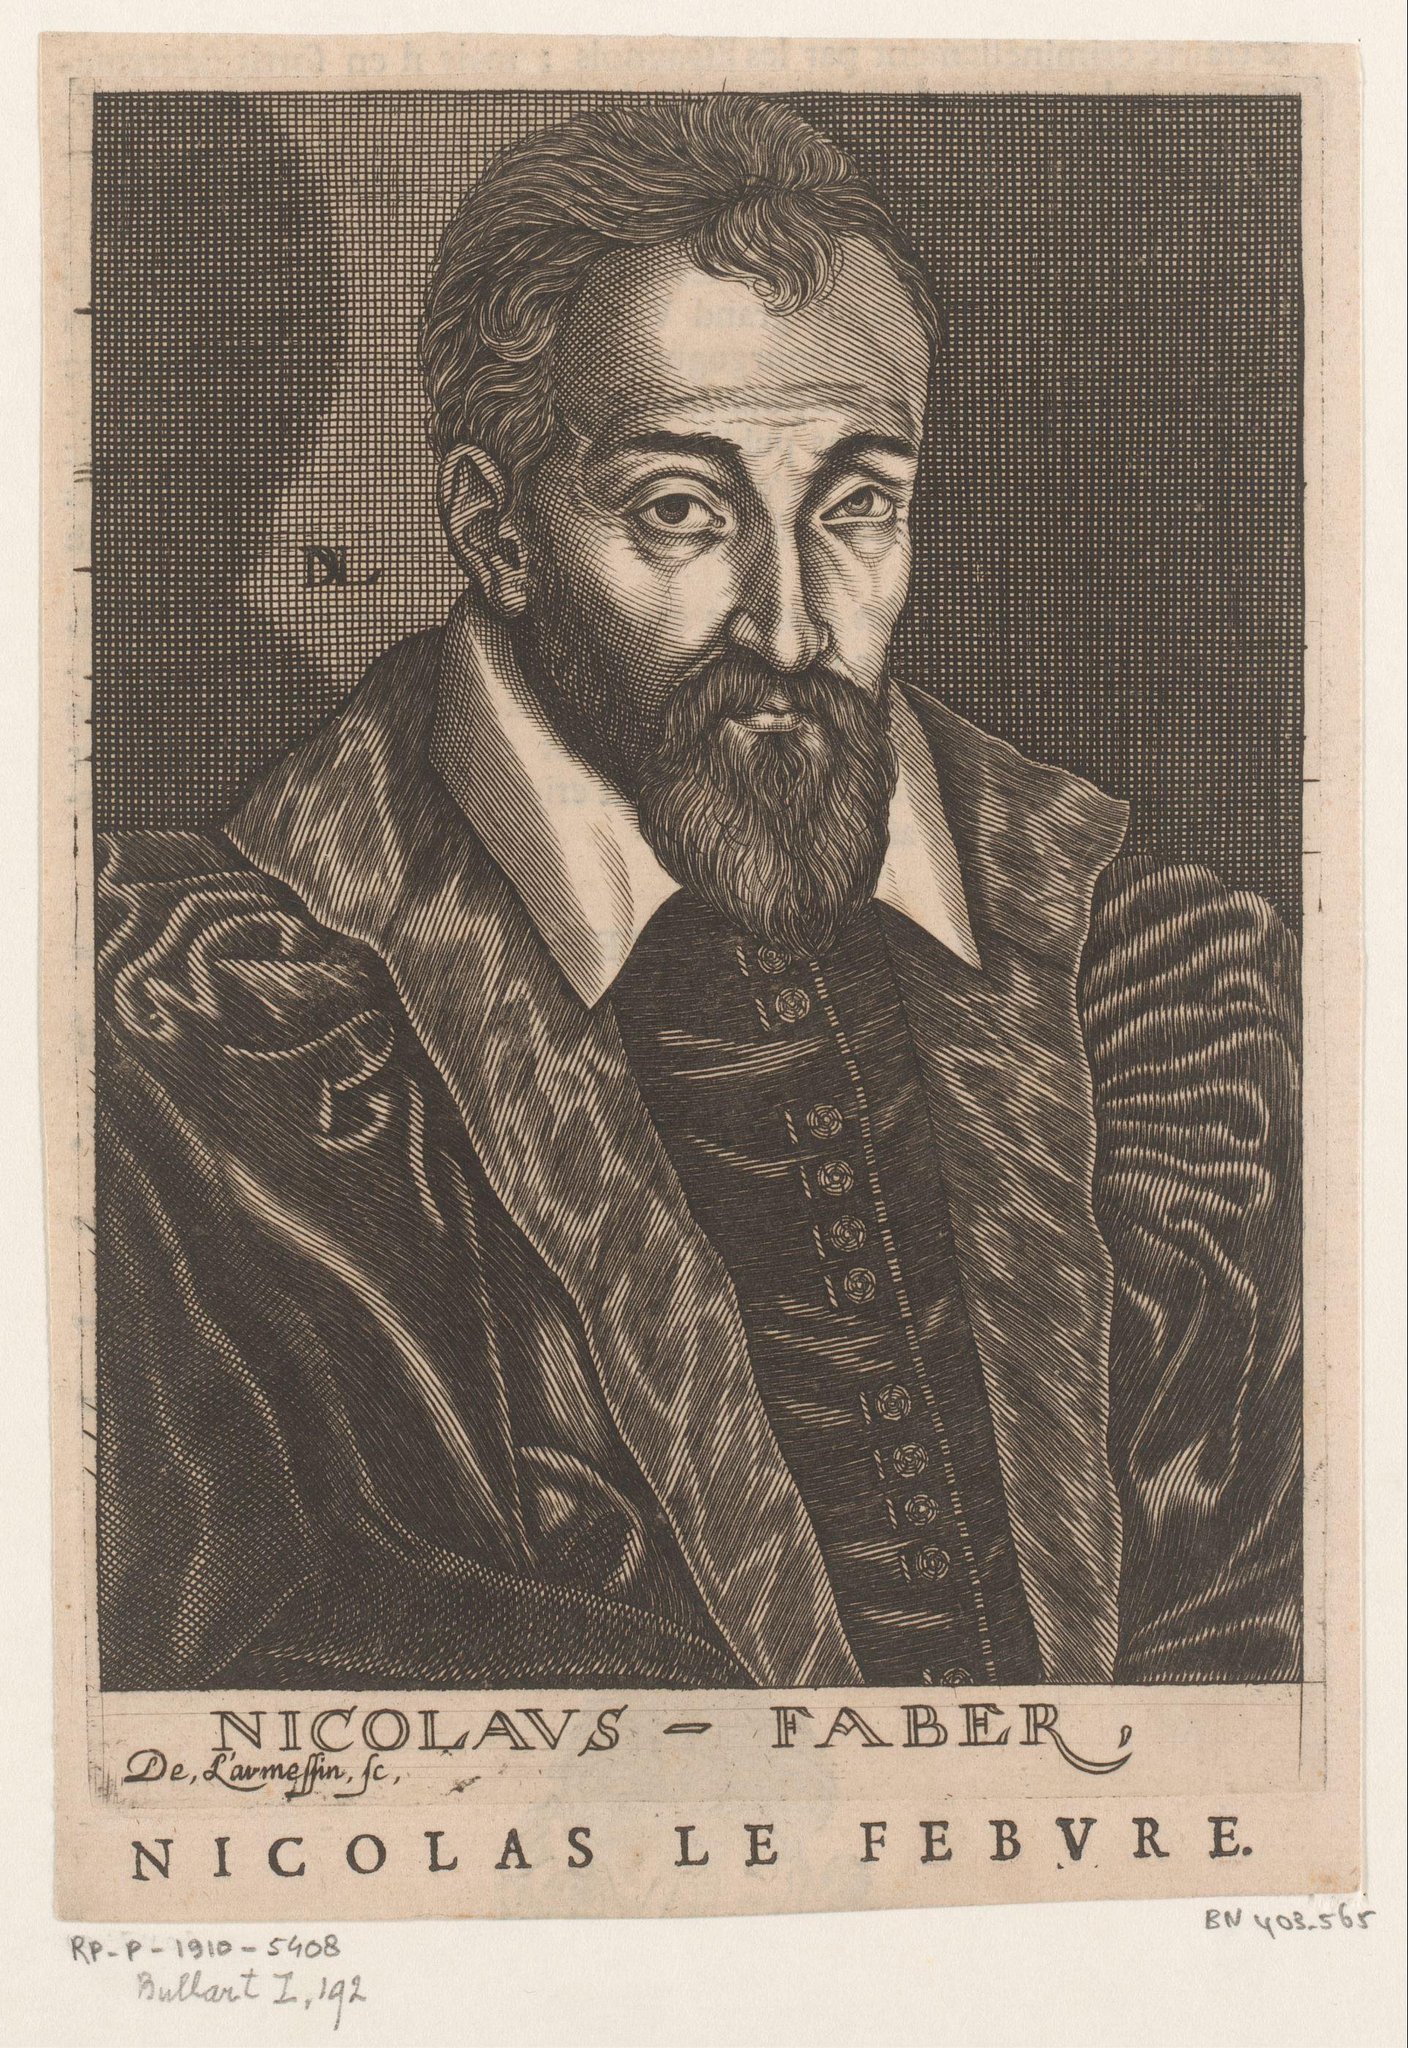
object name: book illustration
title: Portret van Nicolas Lefèvre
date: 1682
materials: paper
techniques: engraving, letterpress printing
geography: brussels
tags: paris, historical persons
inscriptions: collector's mark: Lugt 2228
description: Prent gebruikt voor: Bullart, Isaac. Académie des Sciences et Arts contenant les vies et éloges his. des hommes illustres qui ont excellé en ces professions depuis environ quatre siècles. Brussel: François Foppens, 1682. Het boek werd in 1682 eveneens in Amsterdam uitgegeven door de erfgenamen van Daniel Elzevier. Ieder portret betreft een illustratie bij de biografie van een kunstenaar of geleerde. De meeste portretten werden door Nicolas de Larmessin vervaardigd (162), 93 door De Boulonois en een derde door ongeïdentificeerde prentmakers. Dit betreft een illustratie op p. 192, deel I.